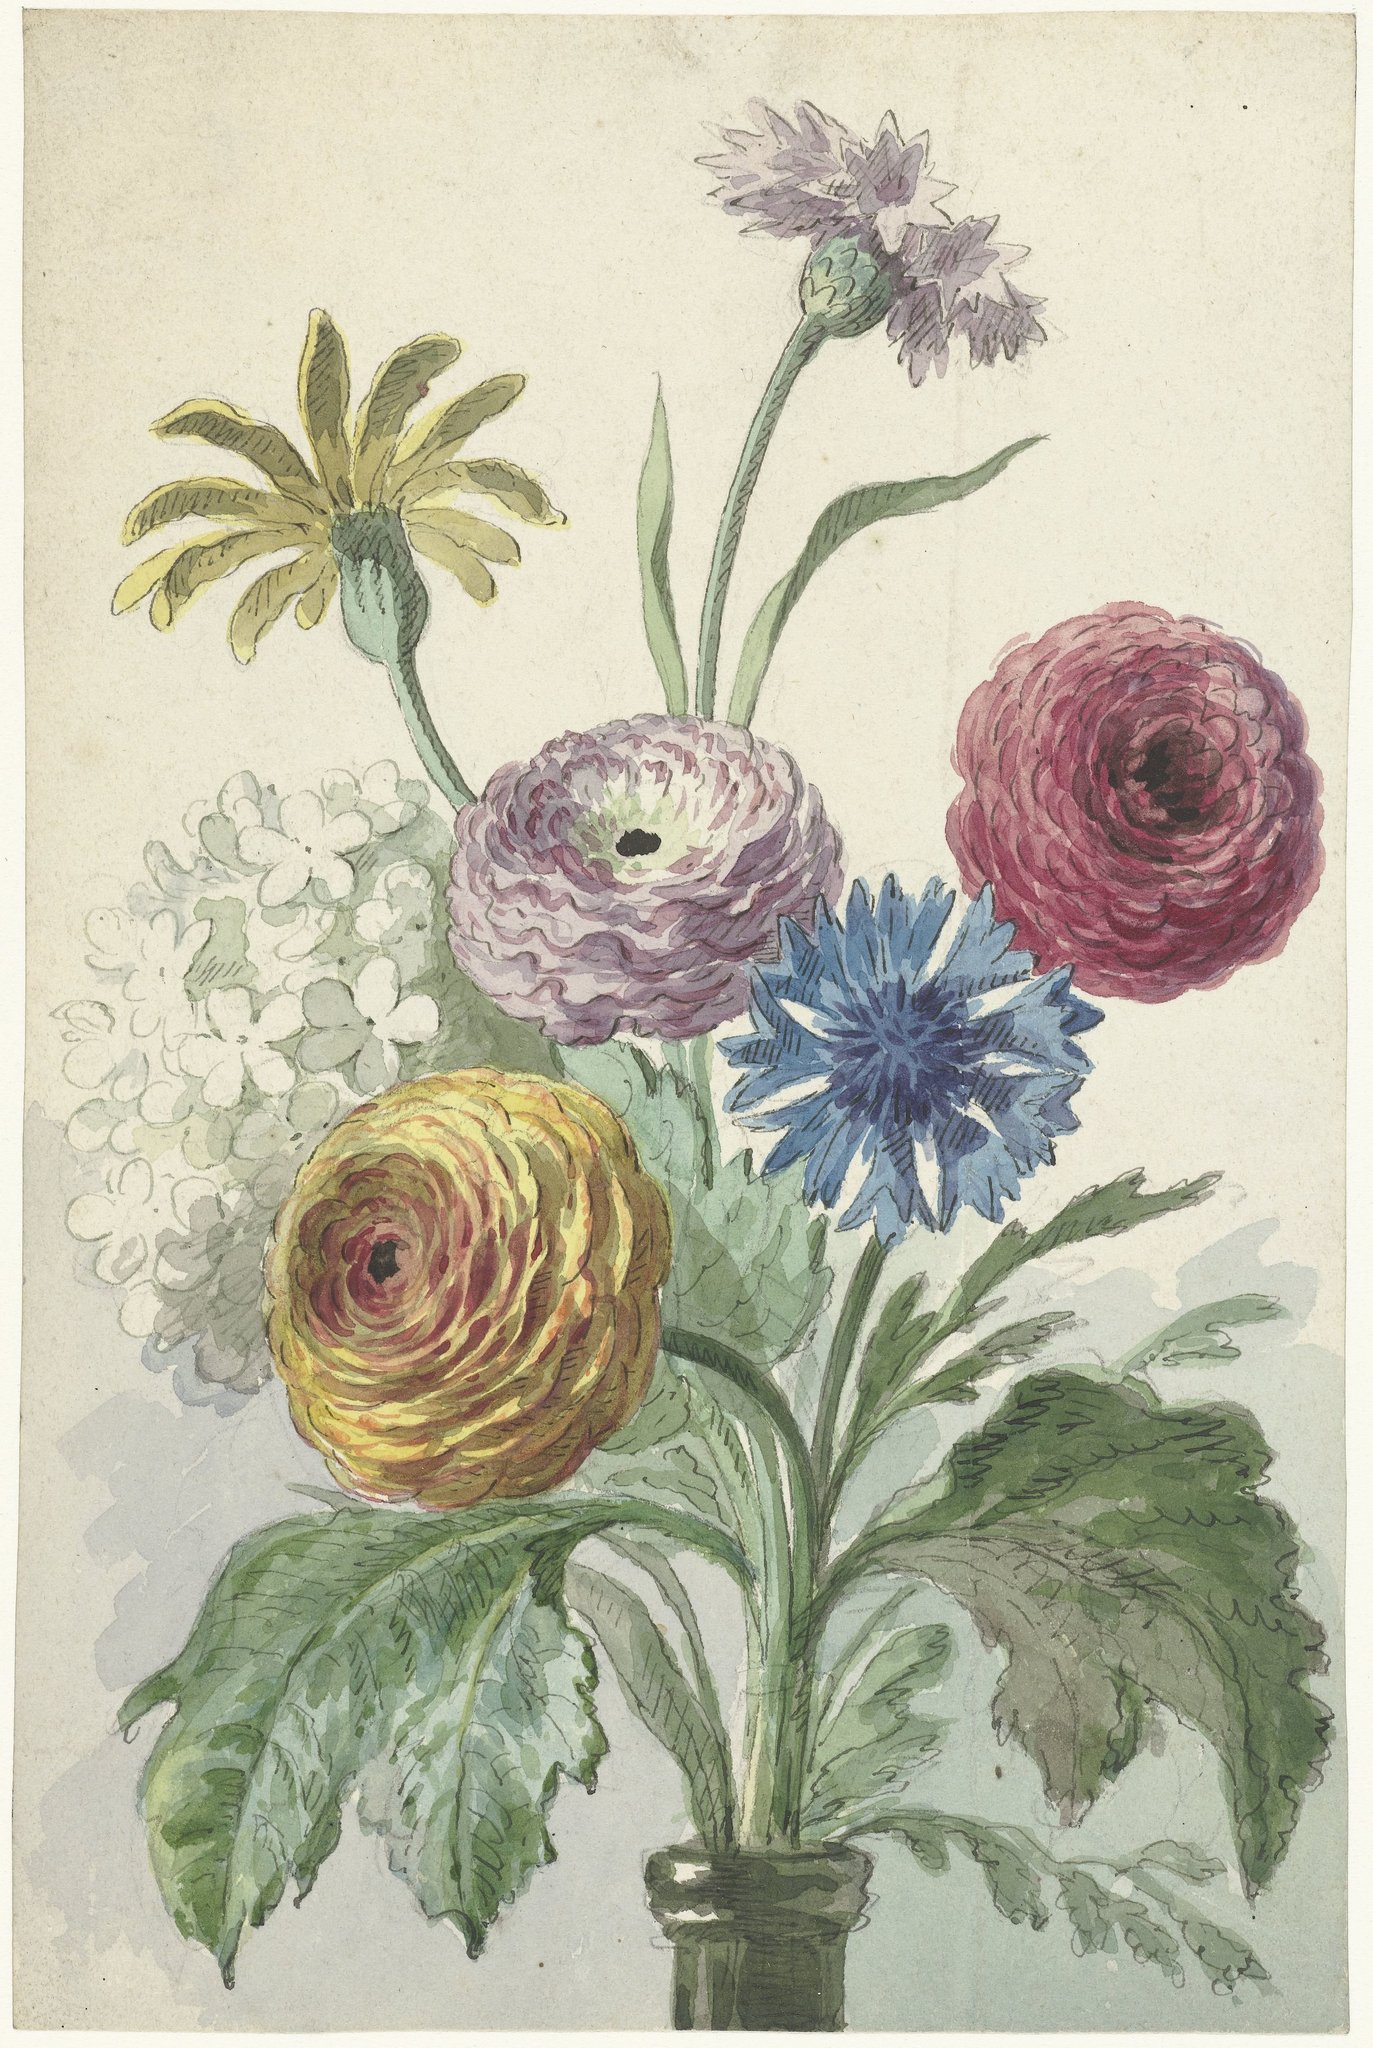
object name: drawing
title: Boeket bloemen in de hals van een groene vaas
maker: willem van leen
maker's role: draughtsman, print maker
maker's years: 1753-1825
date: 1763-1825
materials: chalk, ink, paper, watercolor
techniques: brush, pen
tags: cut flowers; nosegay, bunch of flowers, flowers in a vase